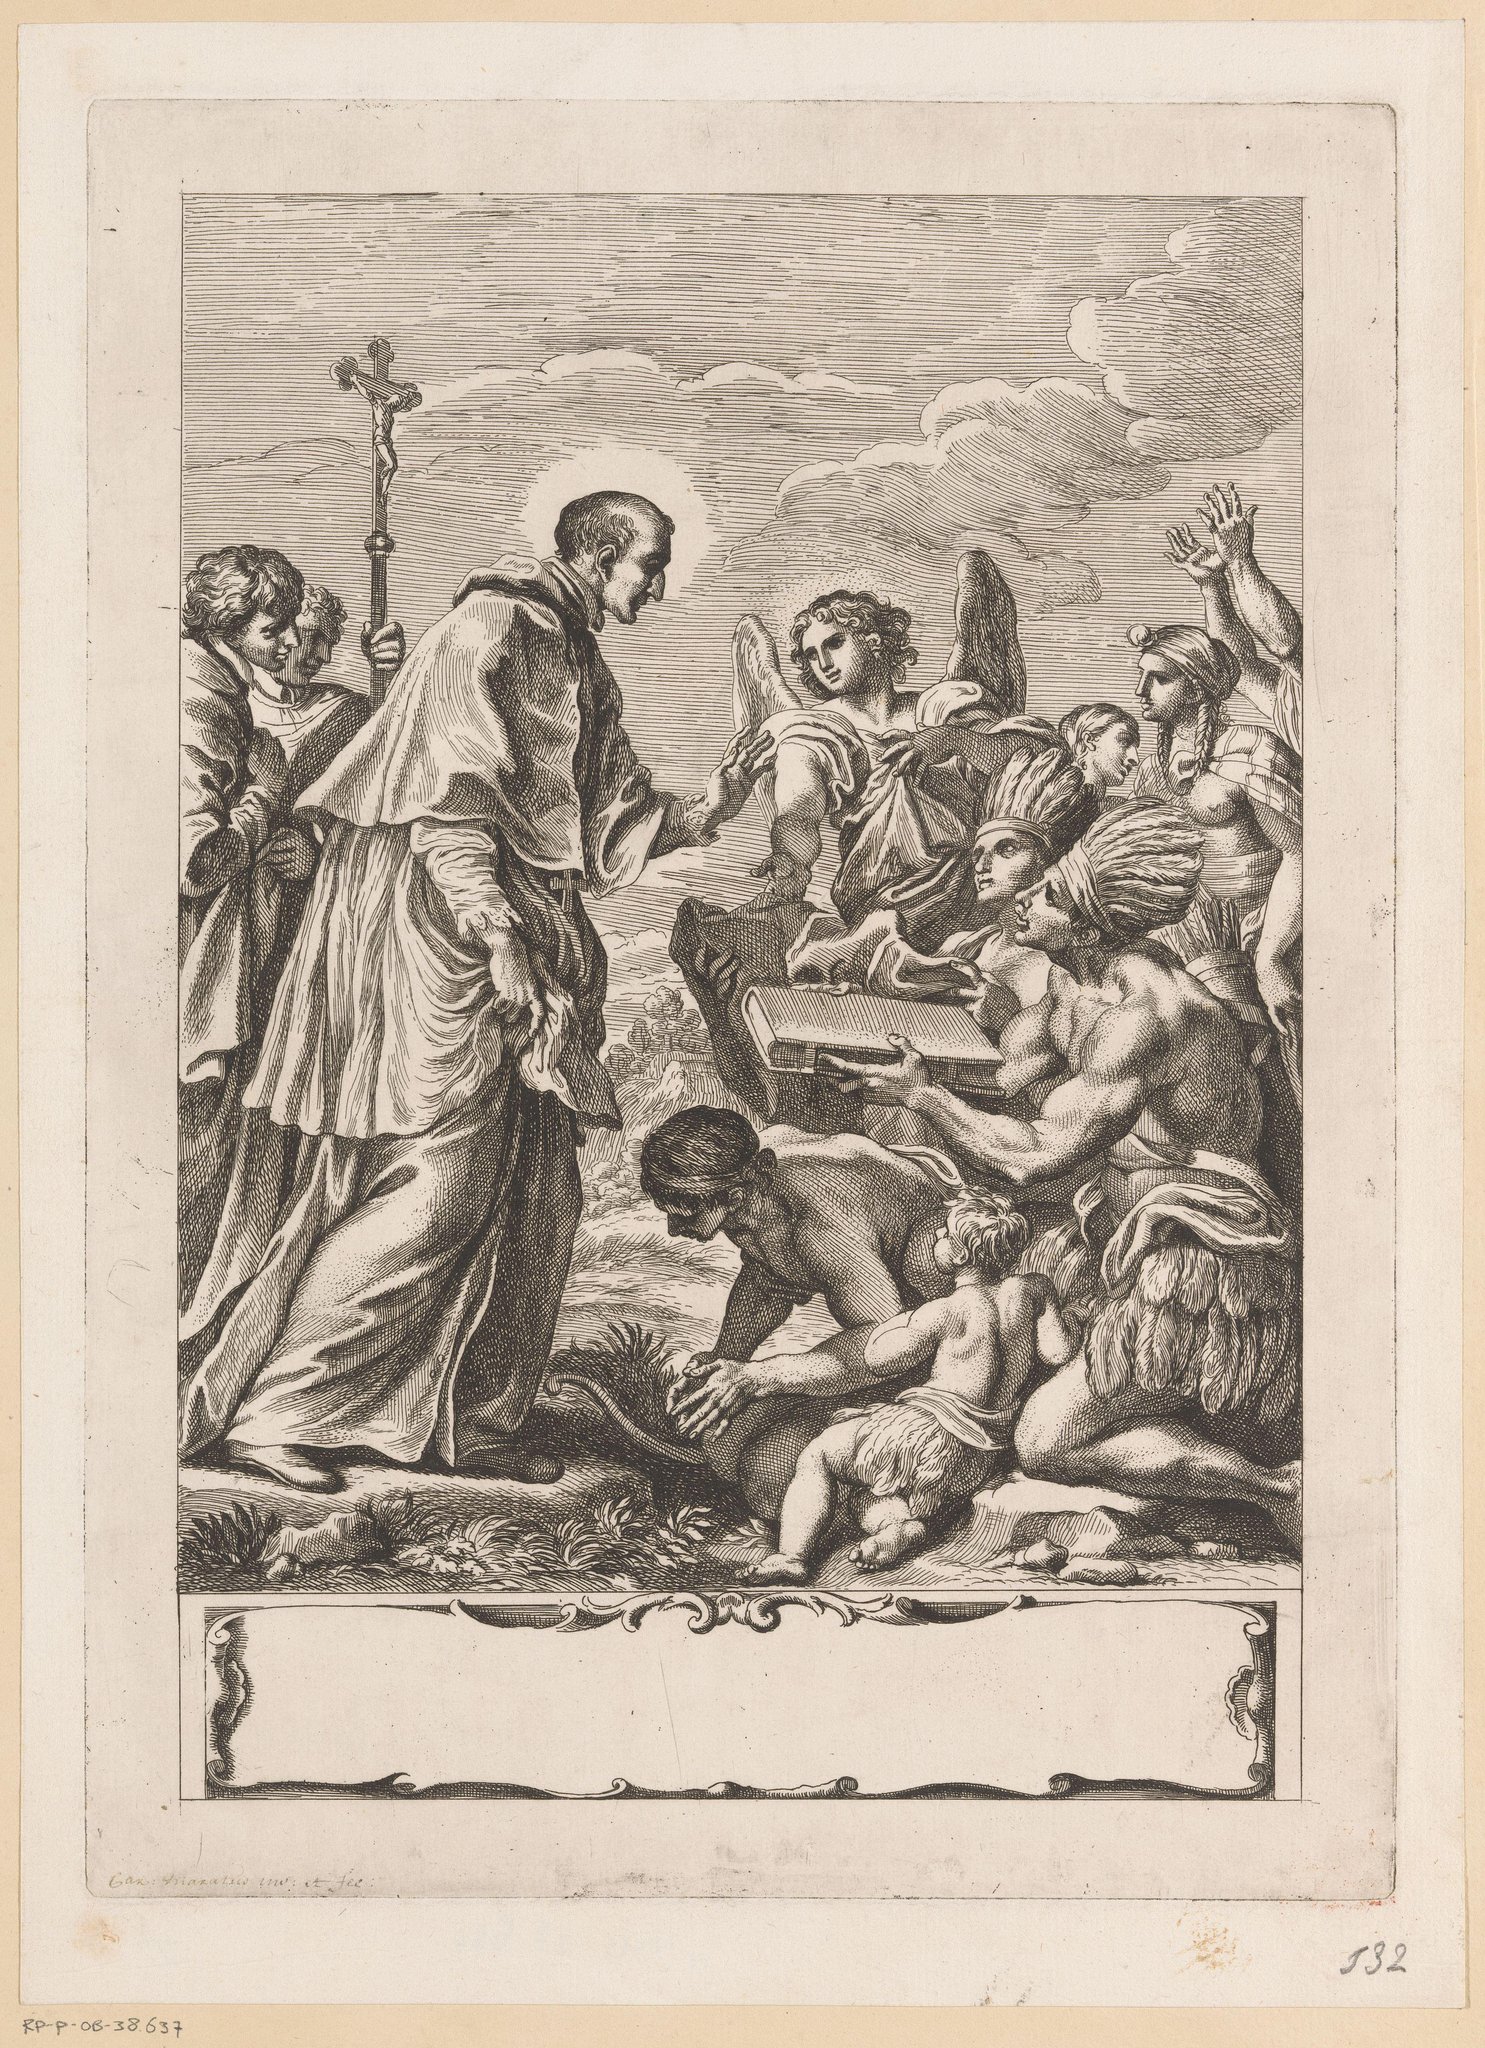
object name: print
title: Leven van de heilige Turibius de Mogrovejo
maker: Anonymous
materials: paper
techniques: etching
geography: italy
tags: turibius de mogrovejo, archbishop, bishop, etc. (roman catholic)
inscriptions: collector's mark: Lugt 240, inscription: ‘Car: Maratus inv: et fec:’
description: De heilige Turibius de Mogrovejo, aartsbisschop van Lima, staat links. Achter hem staan twee mannen. Voor de aartsbisschop een groep Inca's die een boek aan hem presenteren. Onderaan een lege cartouche.